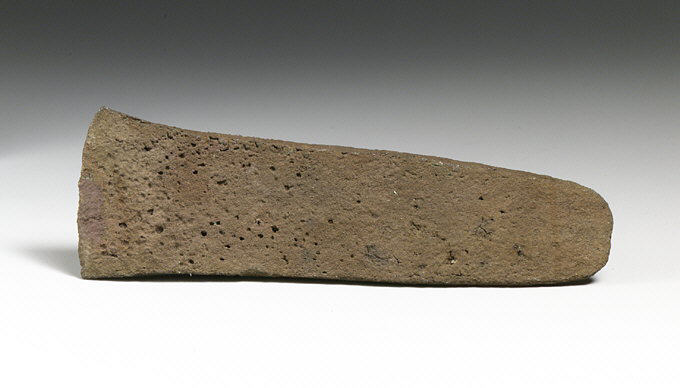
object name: axehead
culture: cypriot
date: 3200-2000 BCE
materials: bronze